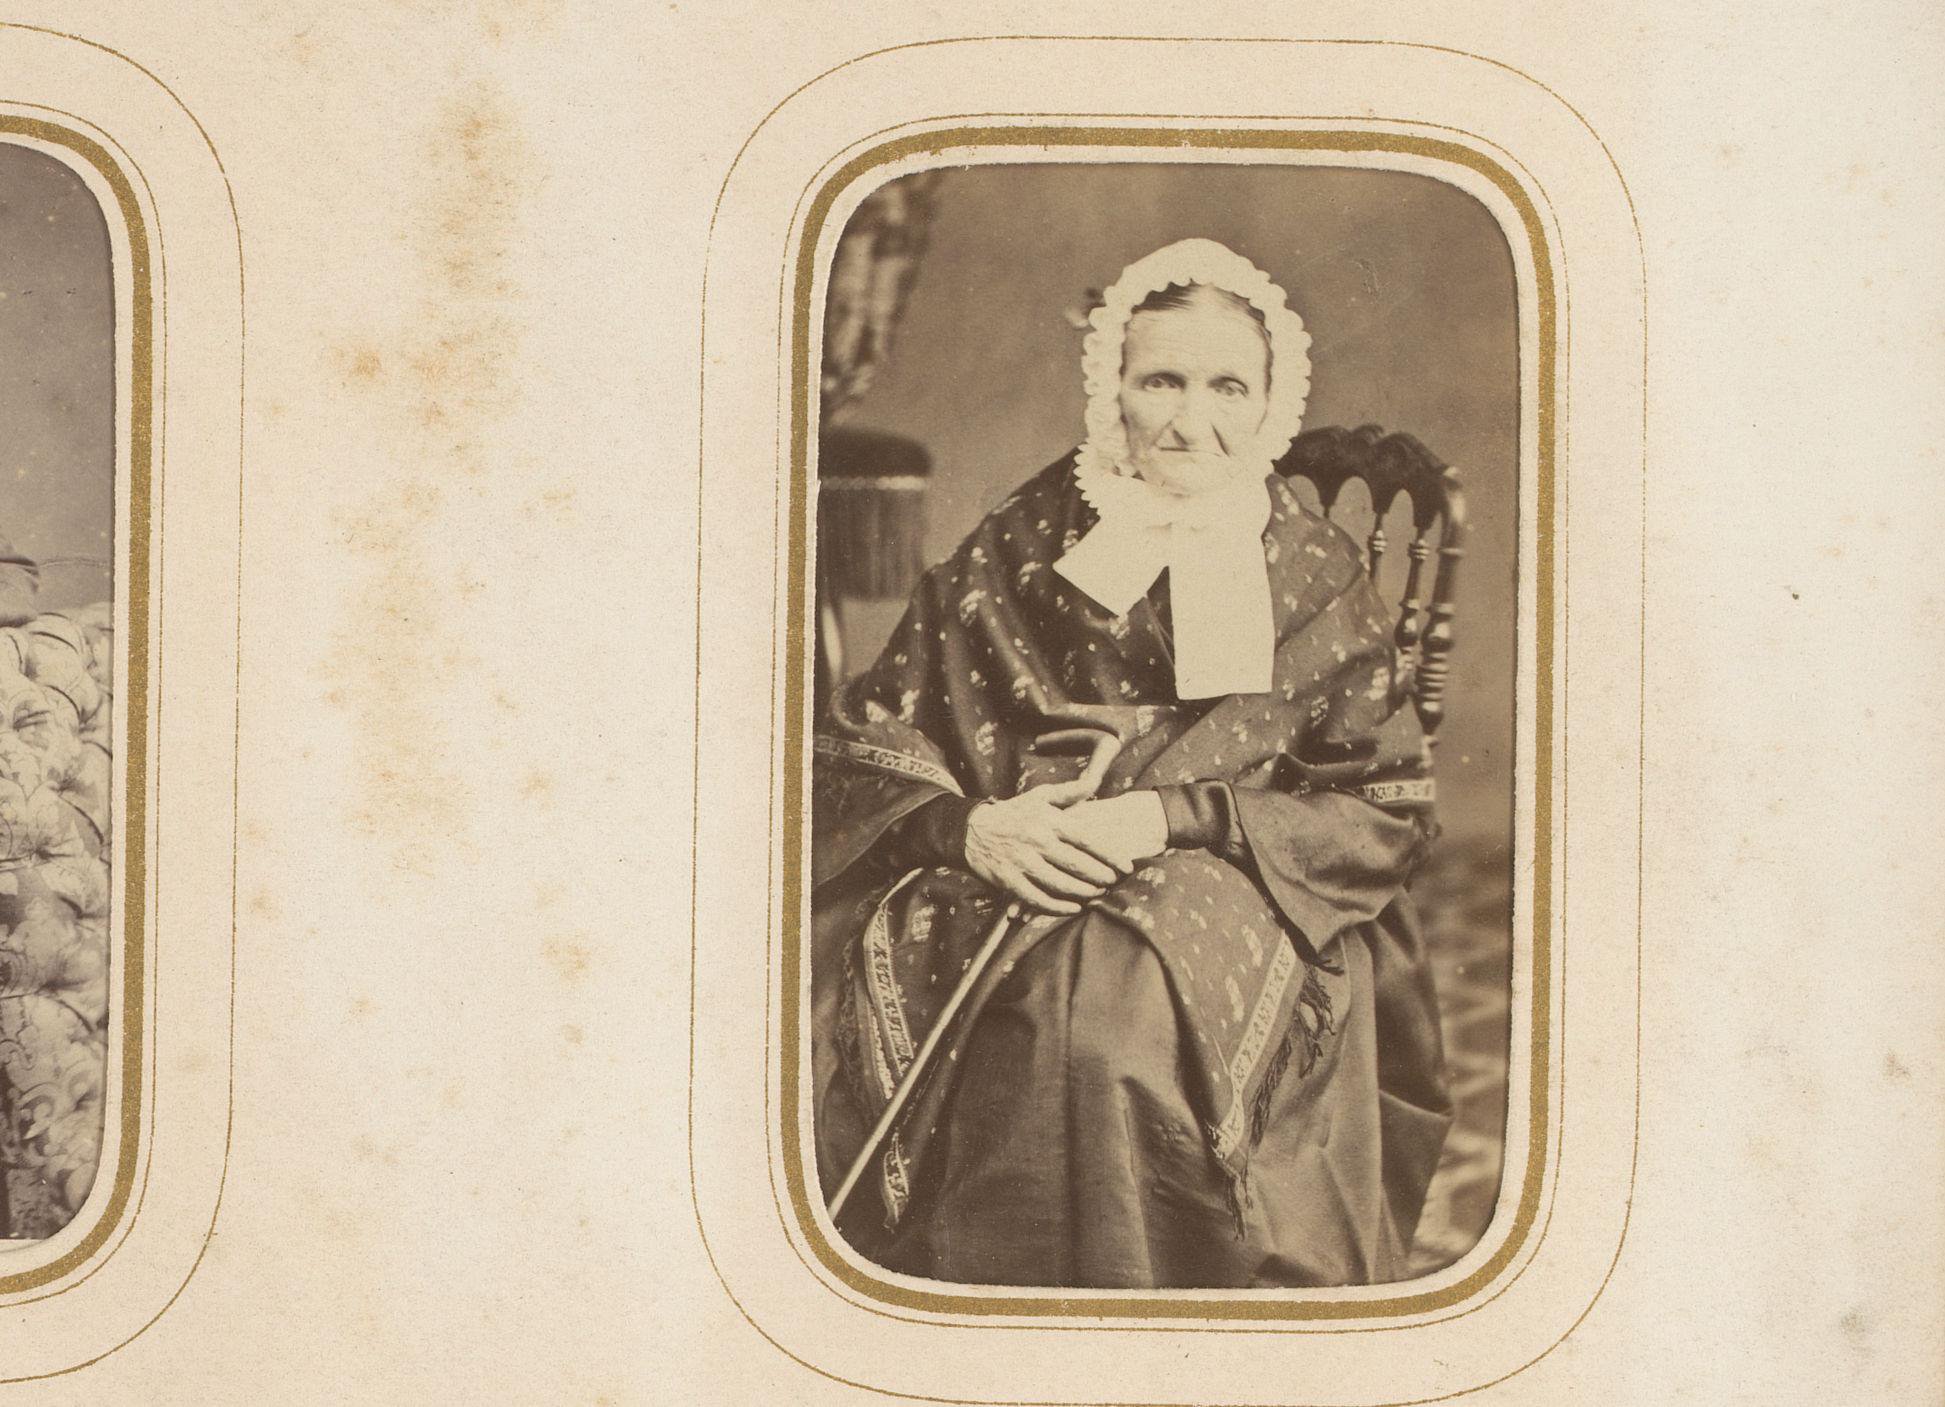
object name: album leaf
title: Portret van een zittende oude vrouw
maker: Anonymous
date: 1860-1890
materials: cardboard, photographic support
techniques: albumen print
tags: historical persons - bb - woman, old woman